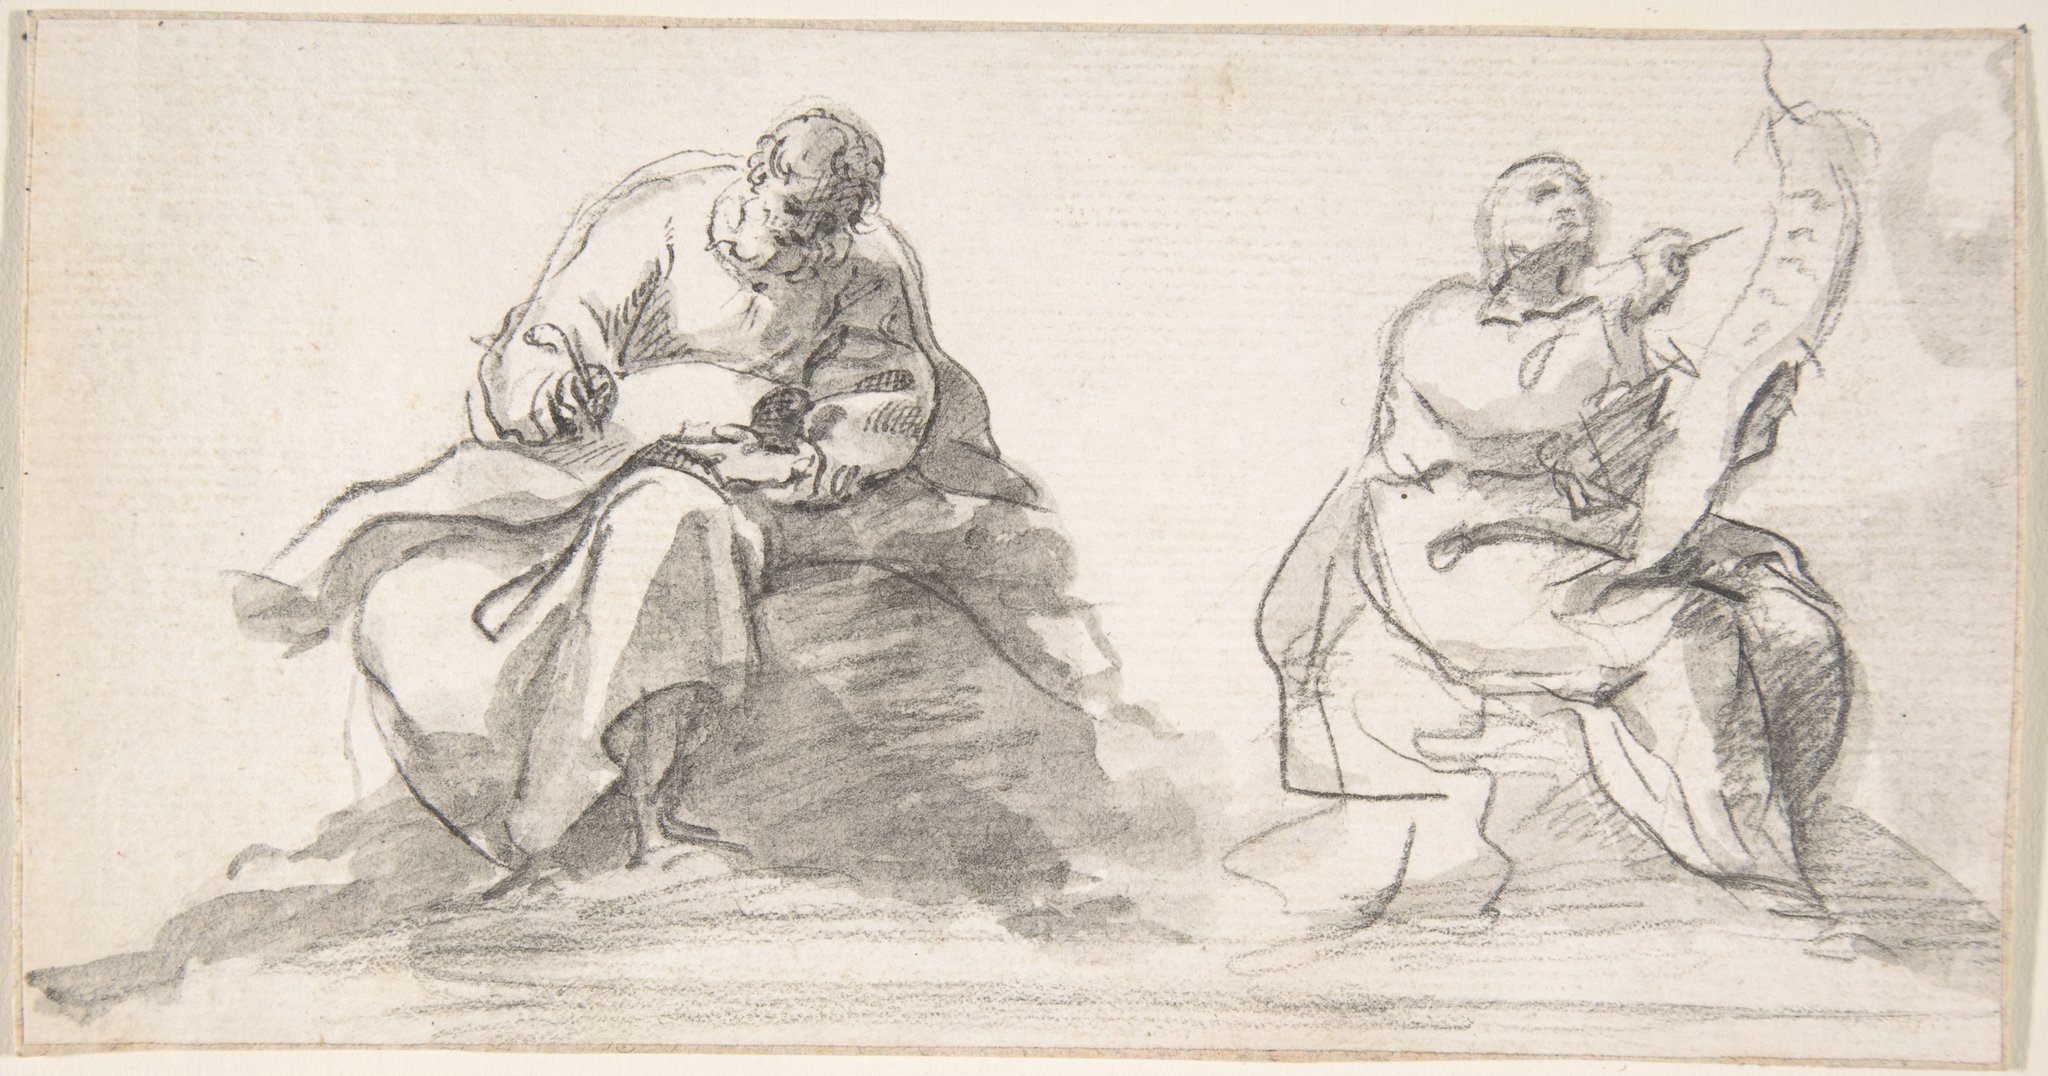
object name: drawing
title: Two Figures of Evangelists Writing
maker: pedro duque cornejo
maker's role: artist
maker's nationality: spanish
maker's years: 1677-1757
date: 1700-1750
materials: chalk, ink, ivory, paper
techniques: brush, pen, drawing, wash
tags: men,writing